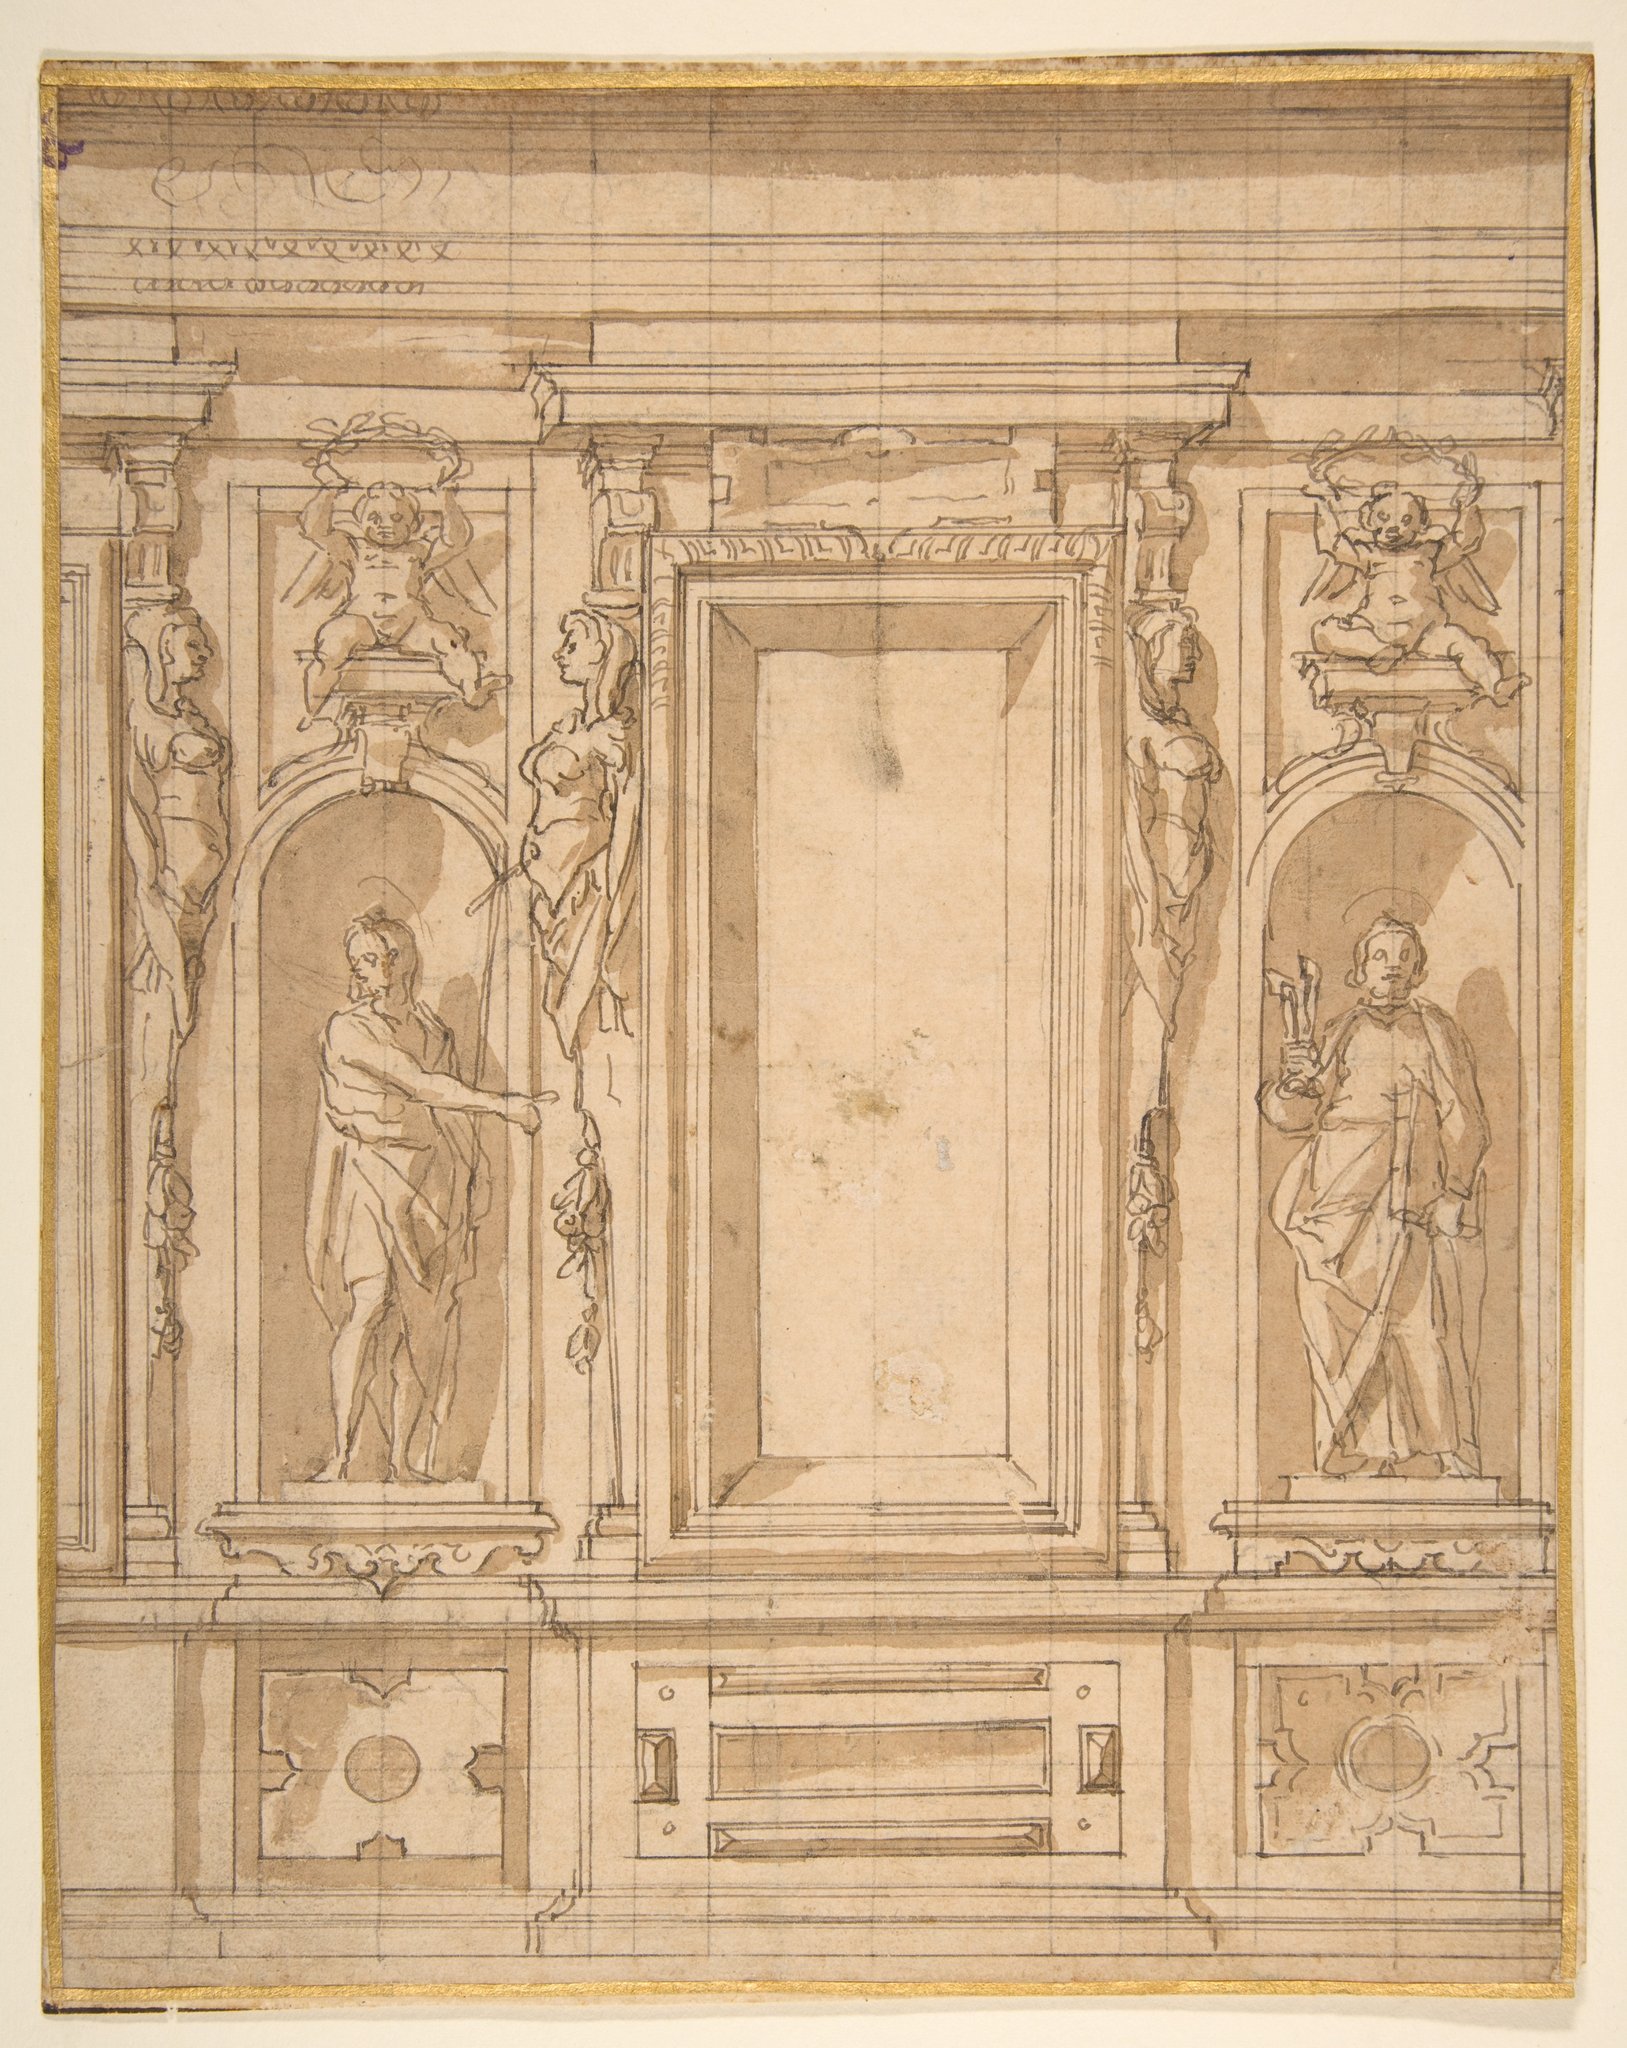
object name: drawing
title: Wall Elevation with a Window and Statues of Saint John the Baptist and Saint Peter in Niches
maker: lazzaro tavarone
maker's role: artist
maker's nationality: italian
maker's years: 1556-1641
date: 1576-1641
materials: chalk, ink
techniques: brush, pen, drawing, wash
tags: windows,caryatids,angels,saint john the baptist,saint peter